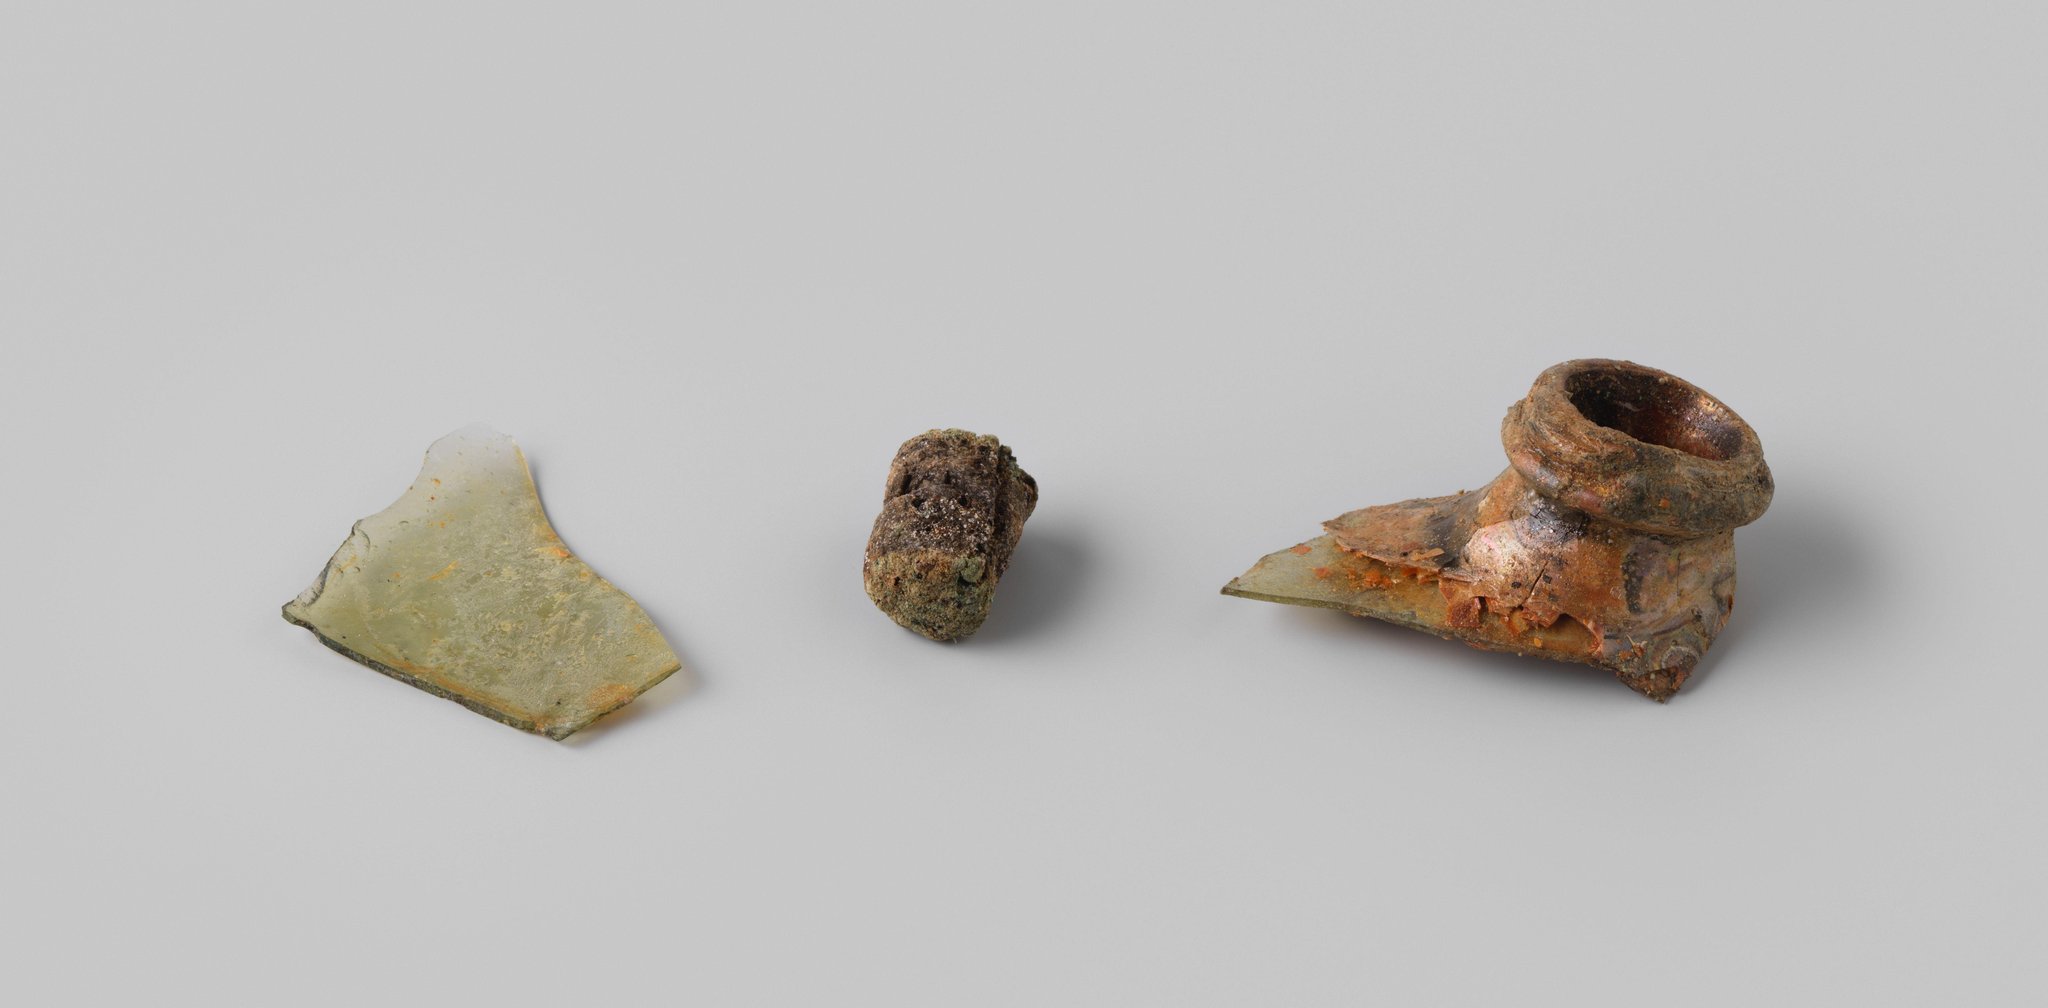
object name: case bottle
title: Hals met kurk en glasscherf van kelderfles uit het wrak van de Oost-Indiëvaarder Hollandia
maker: Anonymous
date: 1700-1743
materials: cork, glass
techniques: green glass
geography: netherlands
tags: verenigde oostindische compagnie, hollandia (schip), annet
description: Case bottle, fragm of belly, eroded; flat.